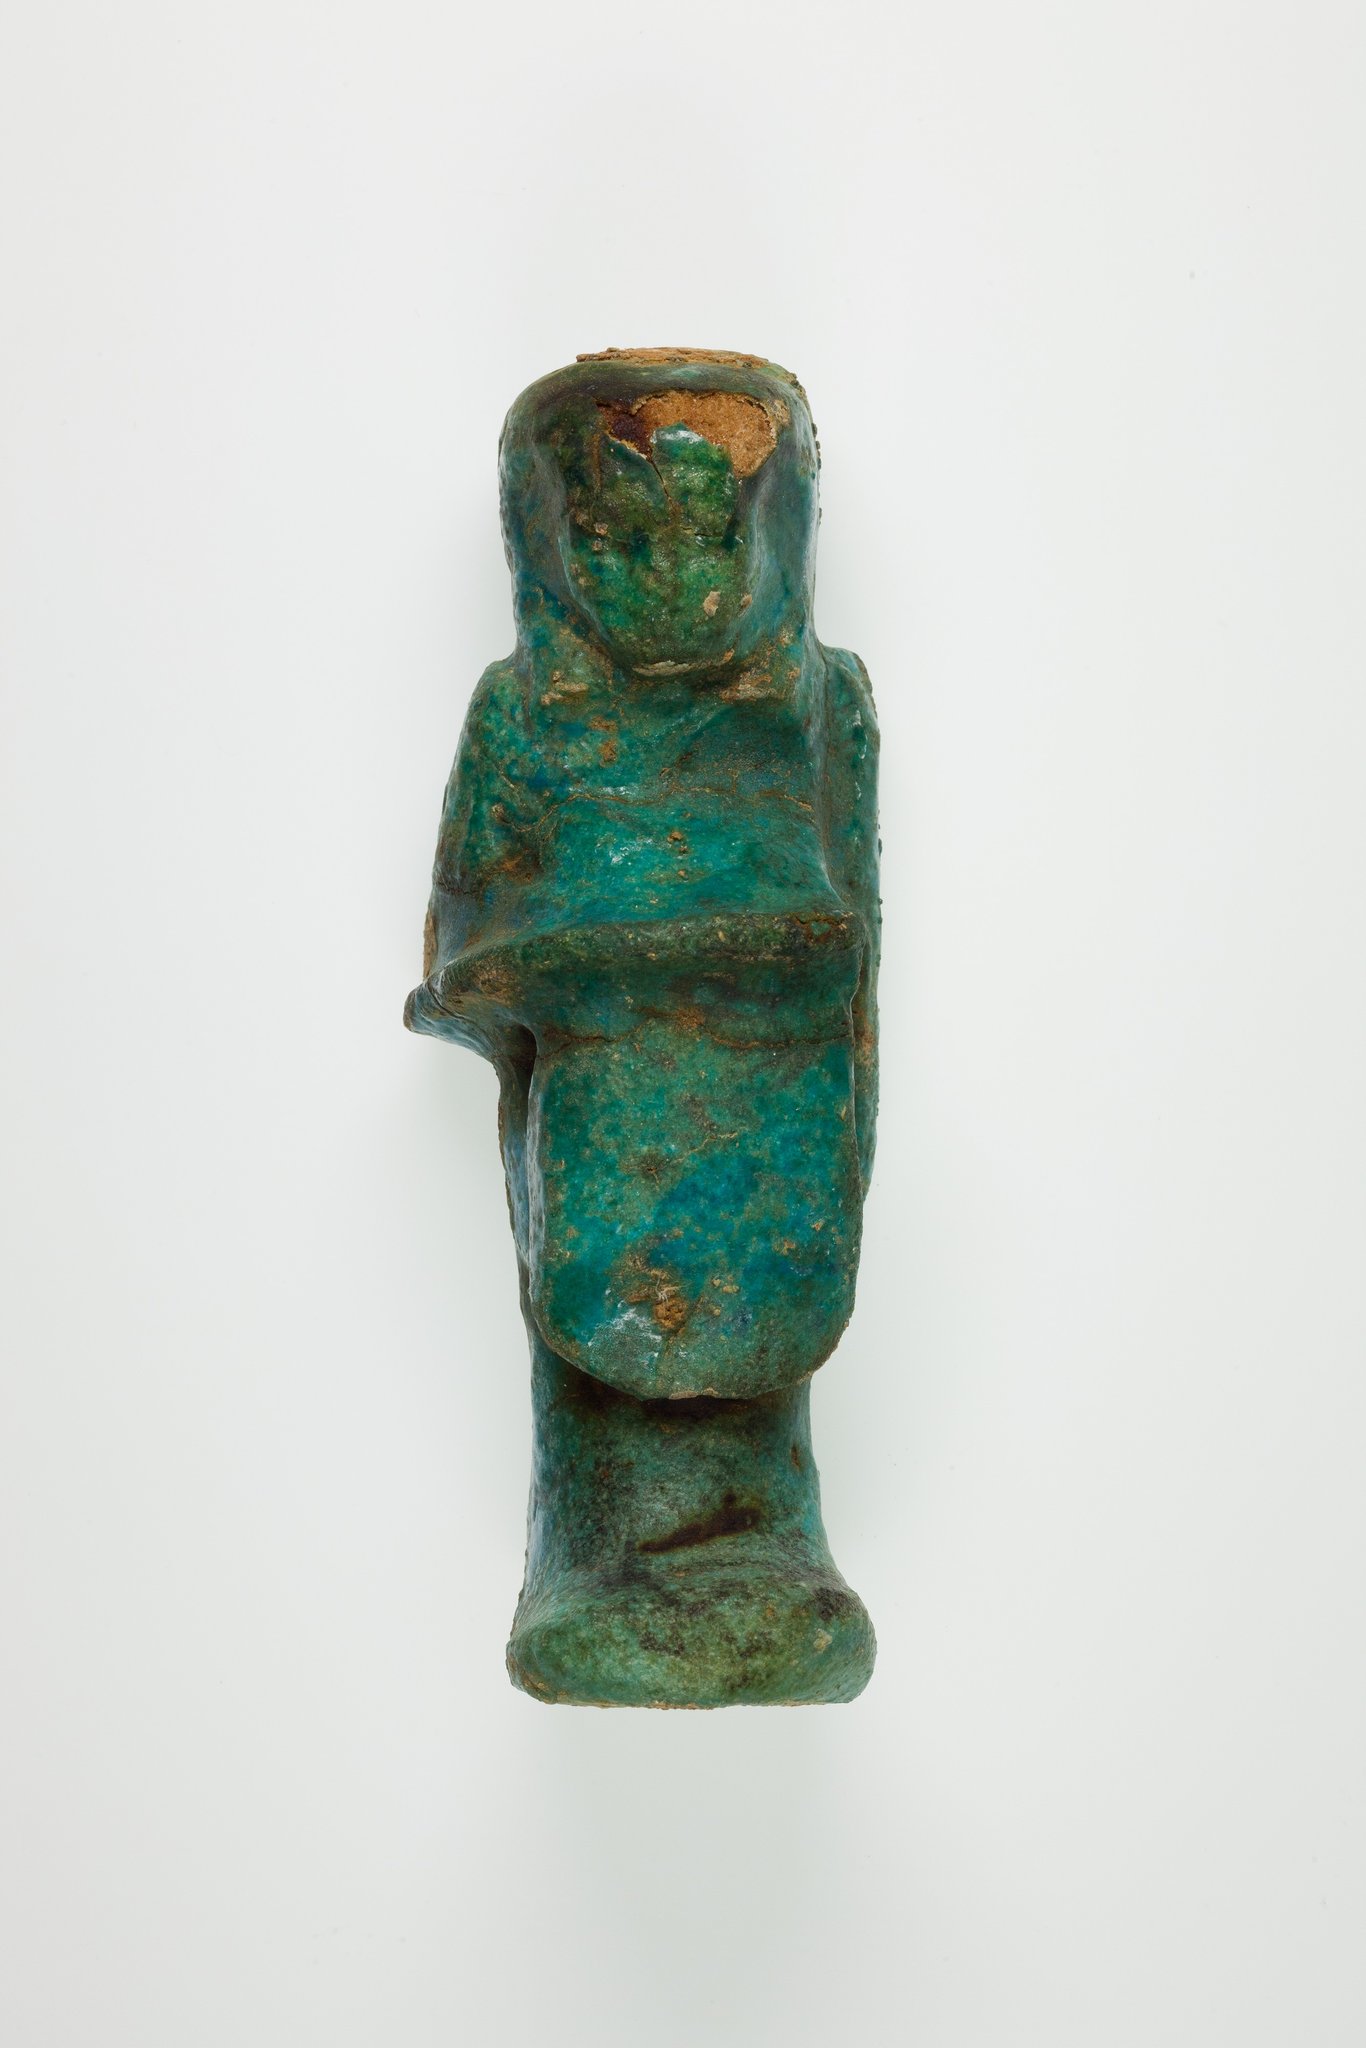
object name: overseer shabti, henettawy c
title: Overseer Shabti of Henettawy (C), Daughter of Isetemkheb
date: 990-970 BCE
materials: faience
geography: egypt